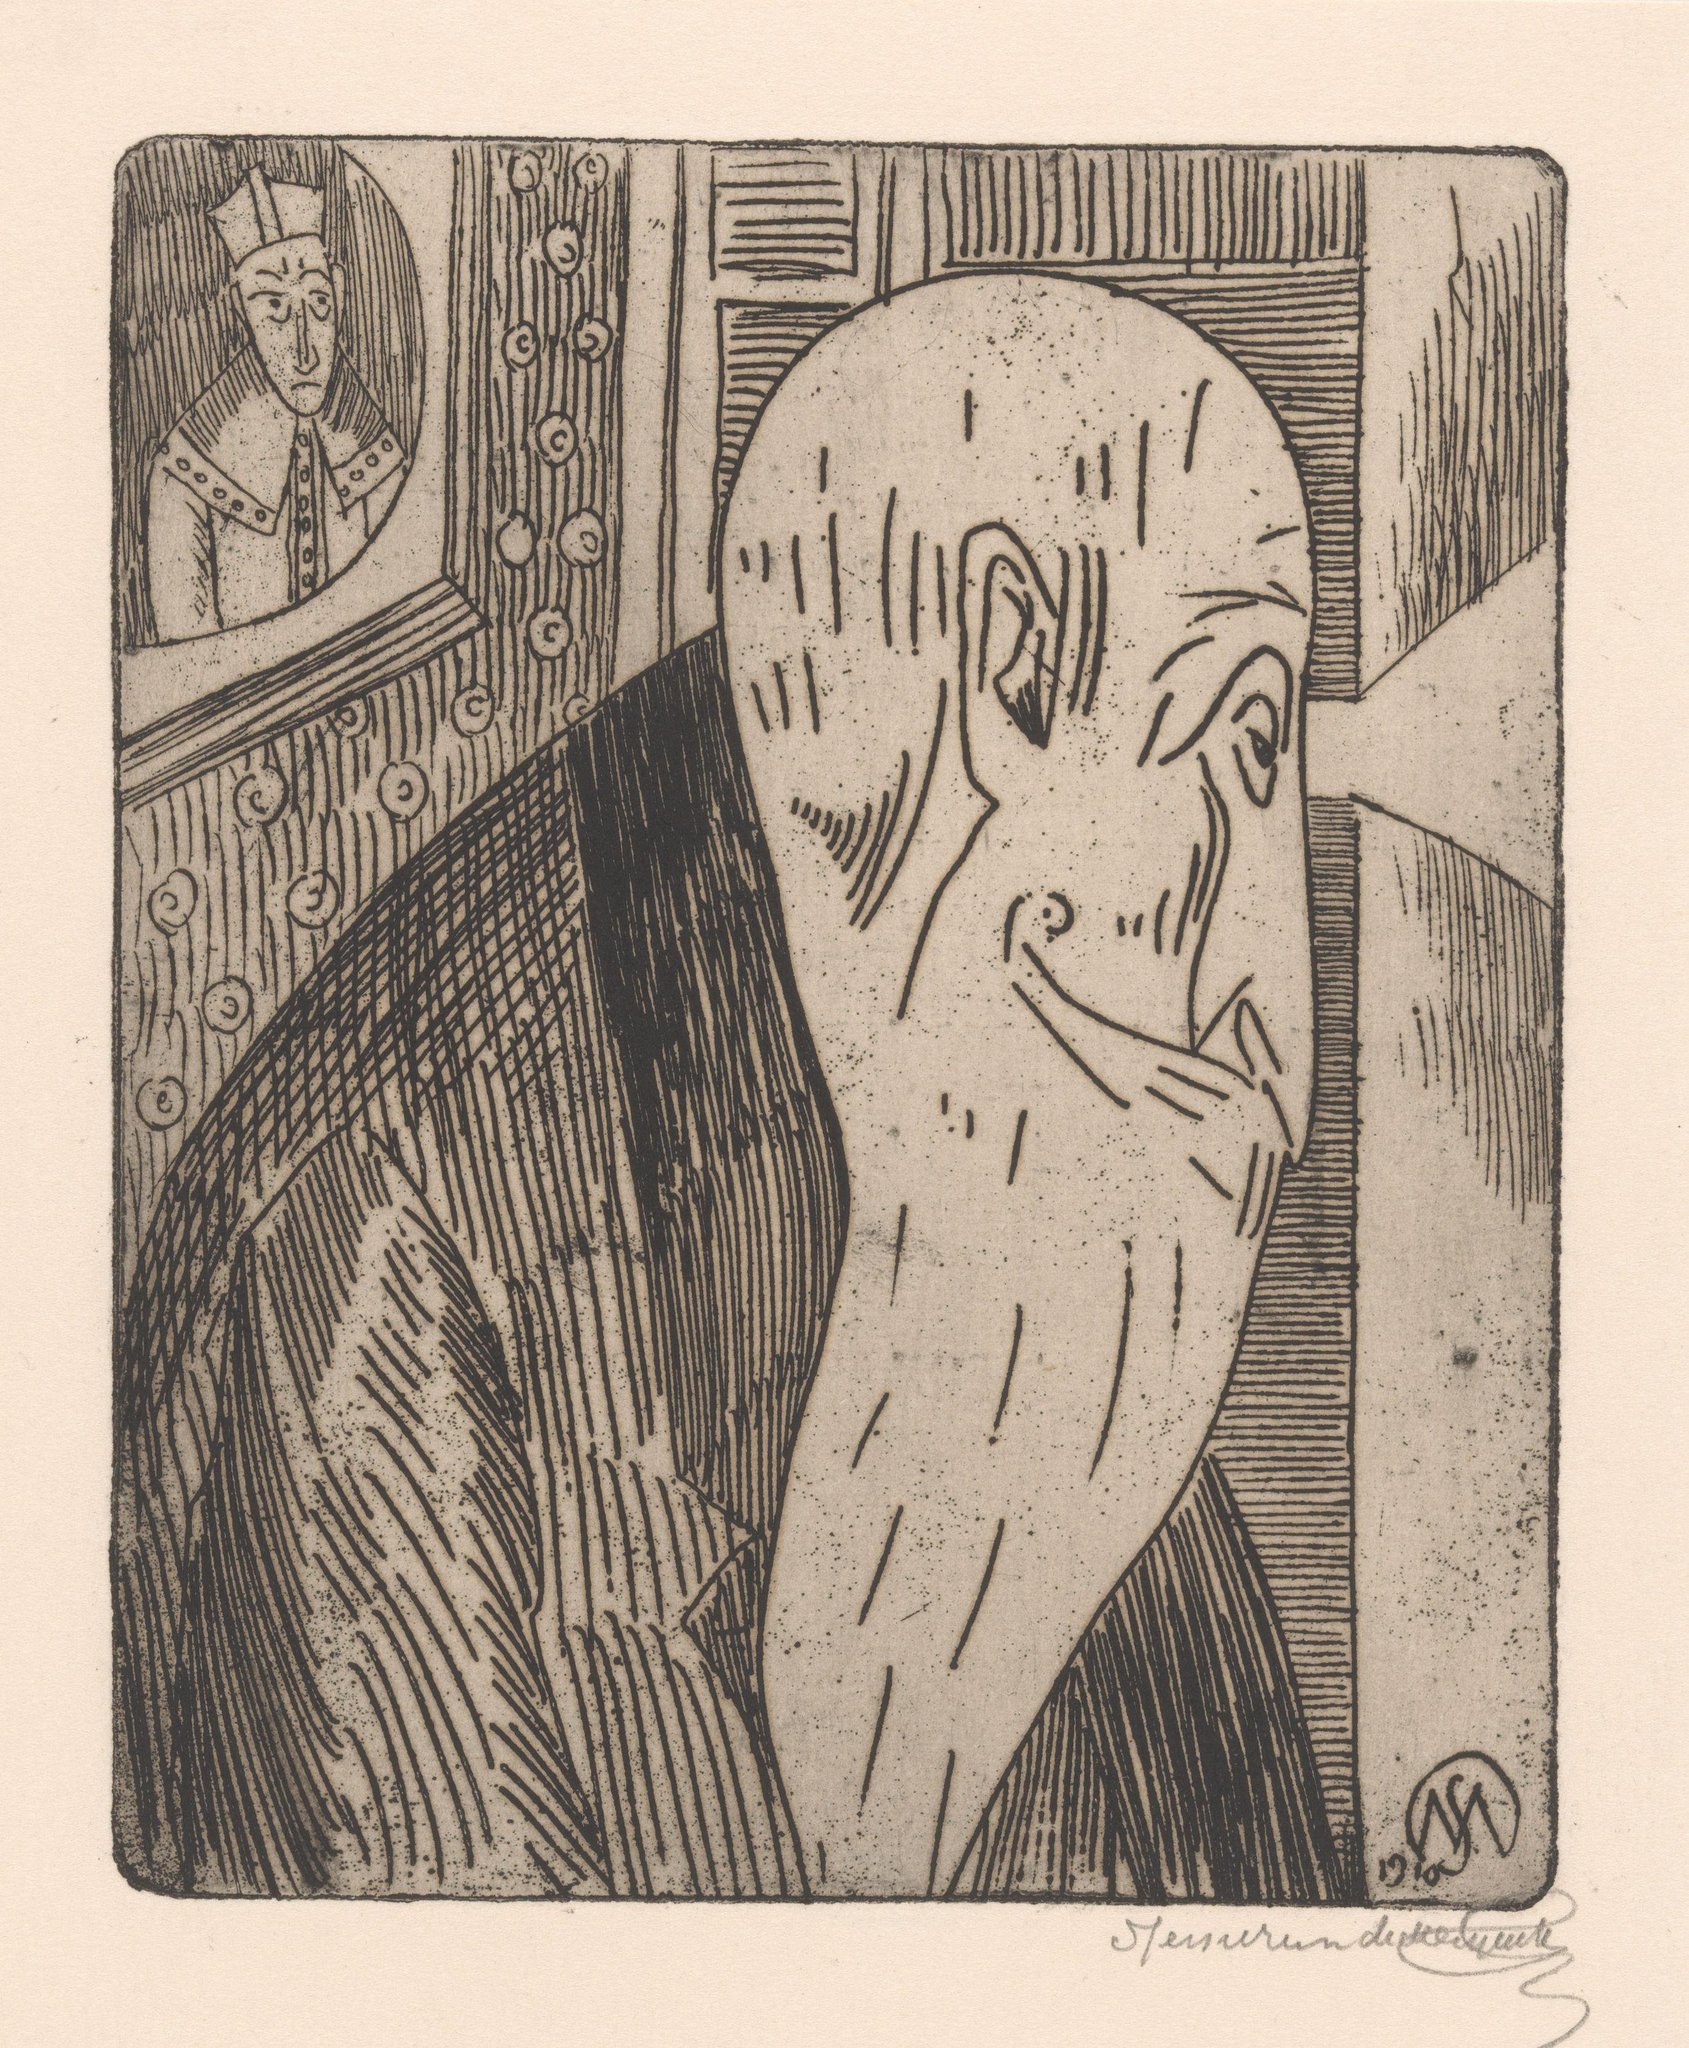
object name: print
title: Groteske verbeeldingen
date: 1910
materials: paper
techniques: etching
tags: looking over the shoulder, old man, beard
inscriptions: collector's mark: Lugt 2228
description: Links een portret van een man met een hoed.